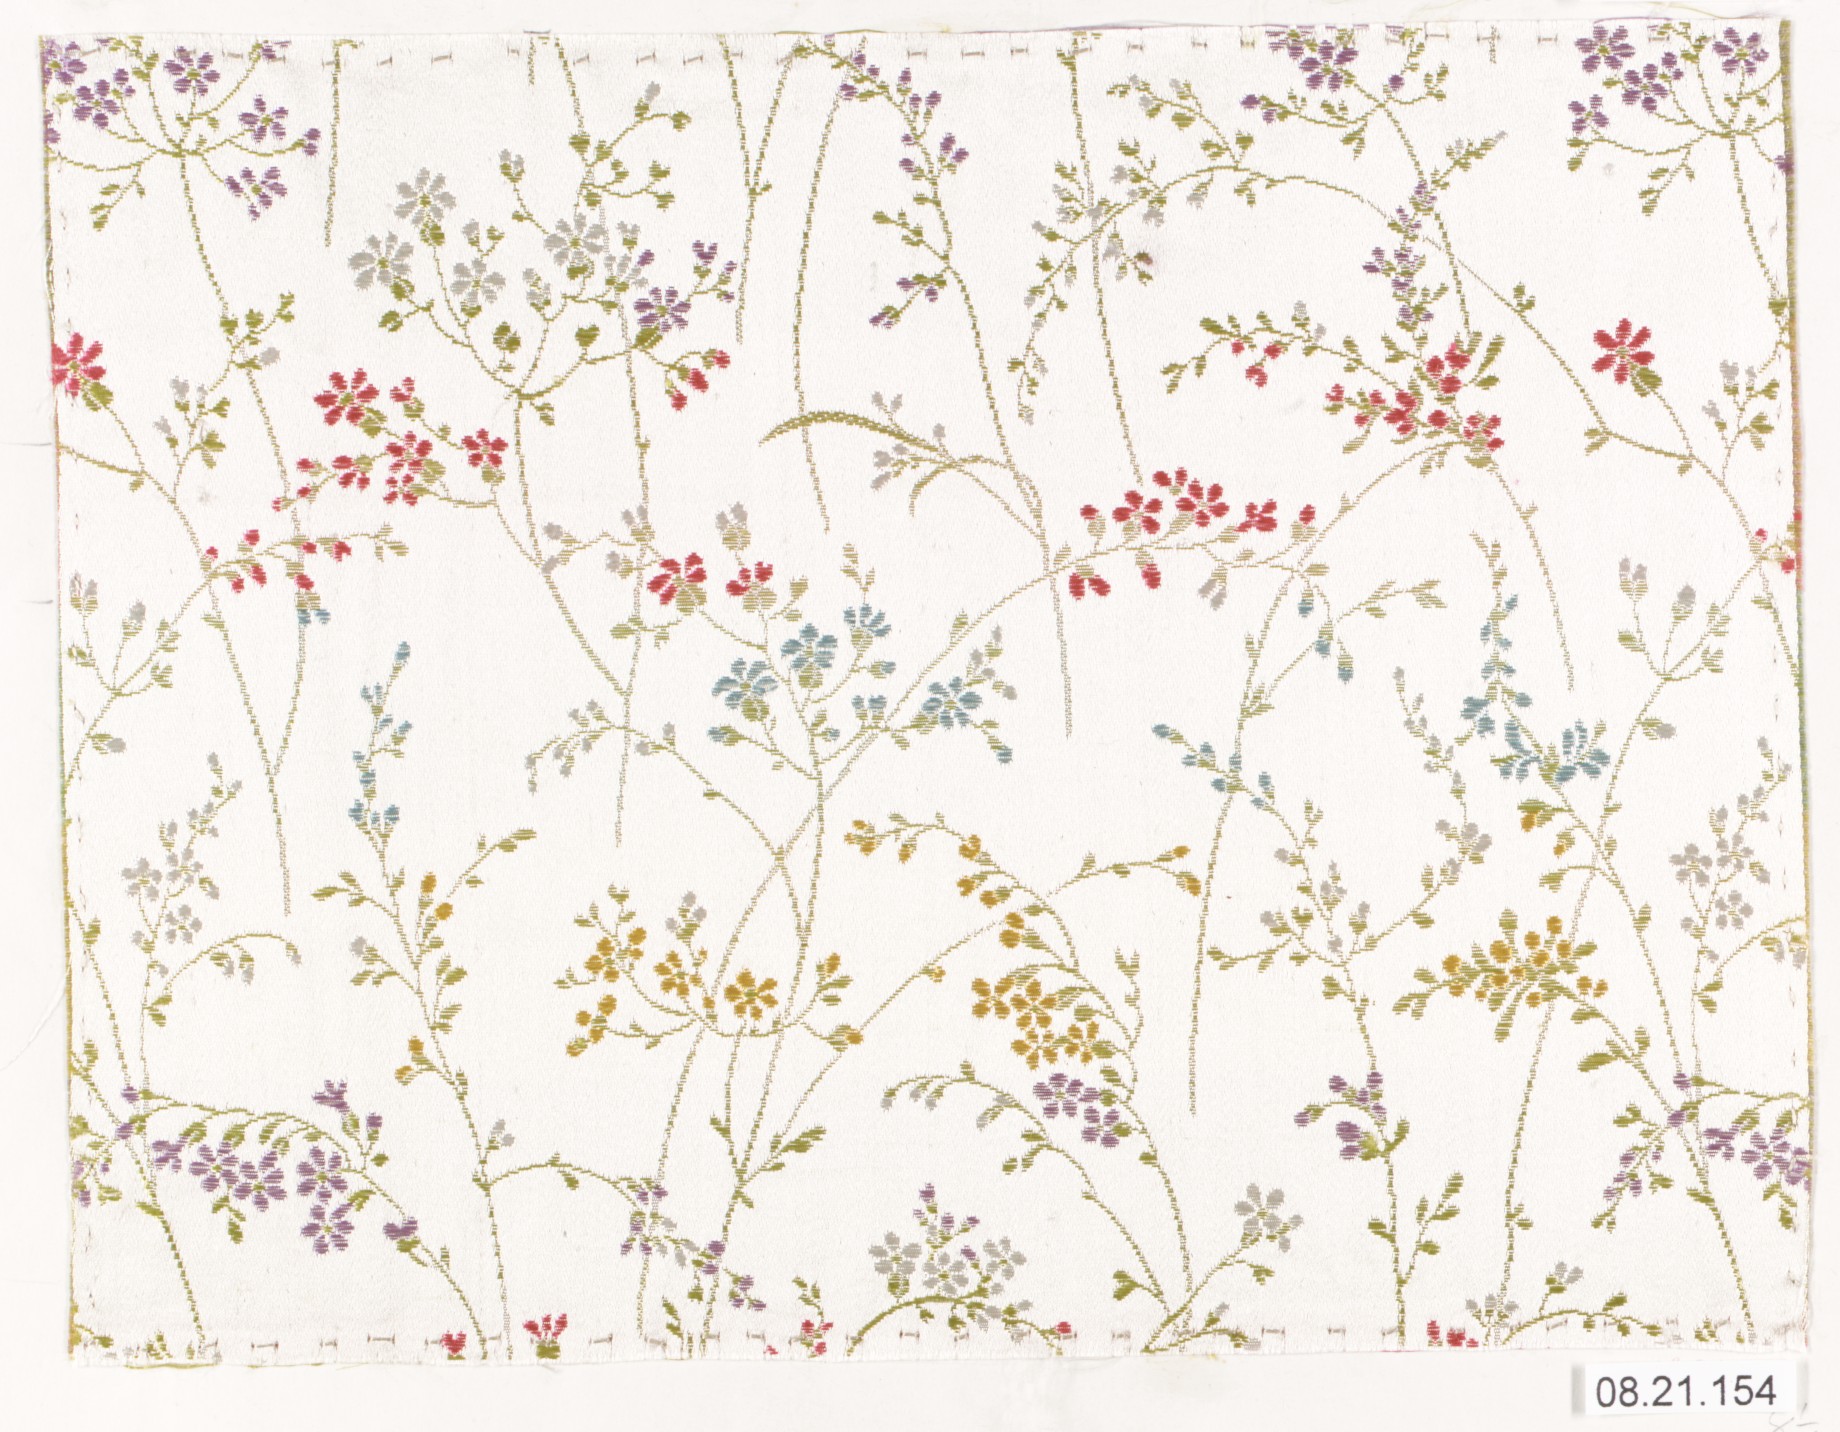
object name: textile sample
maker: Anonymous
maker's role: designer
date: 1900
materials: silk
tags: flowers